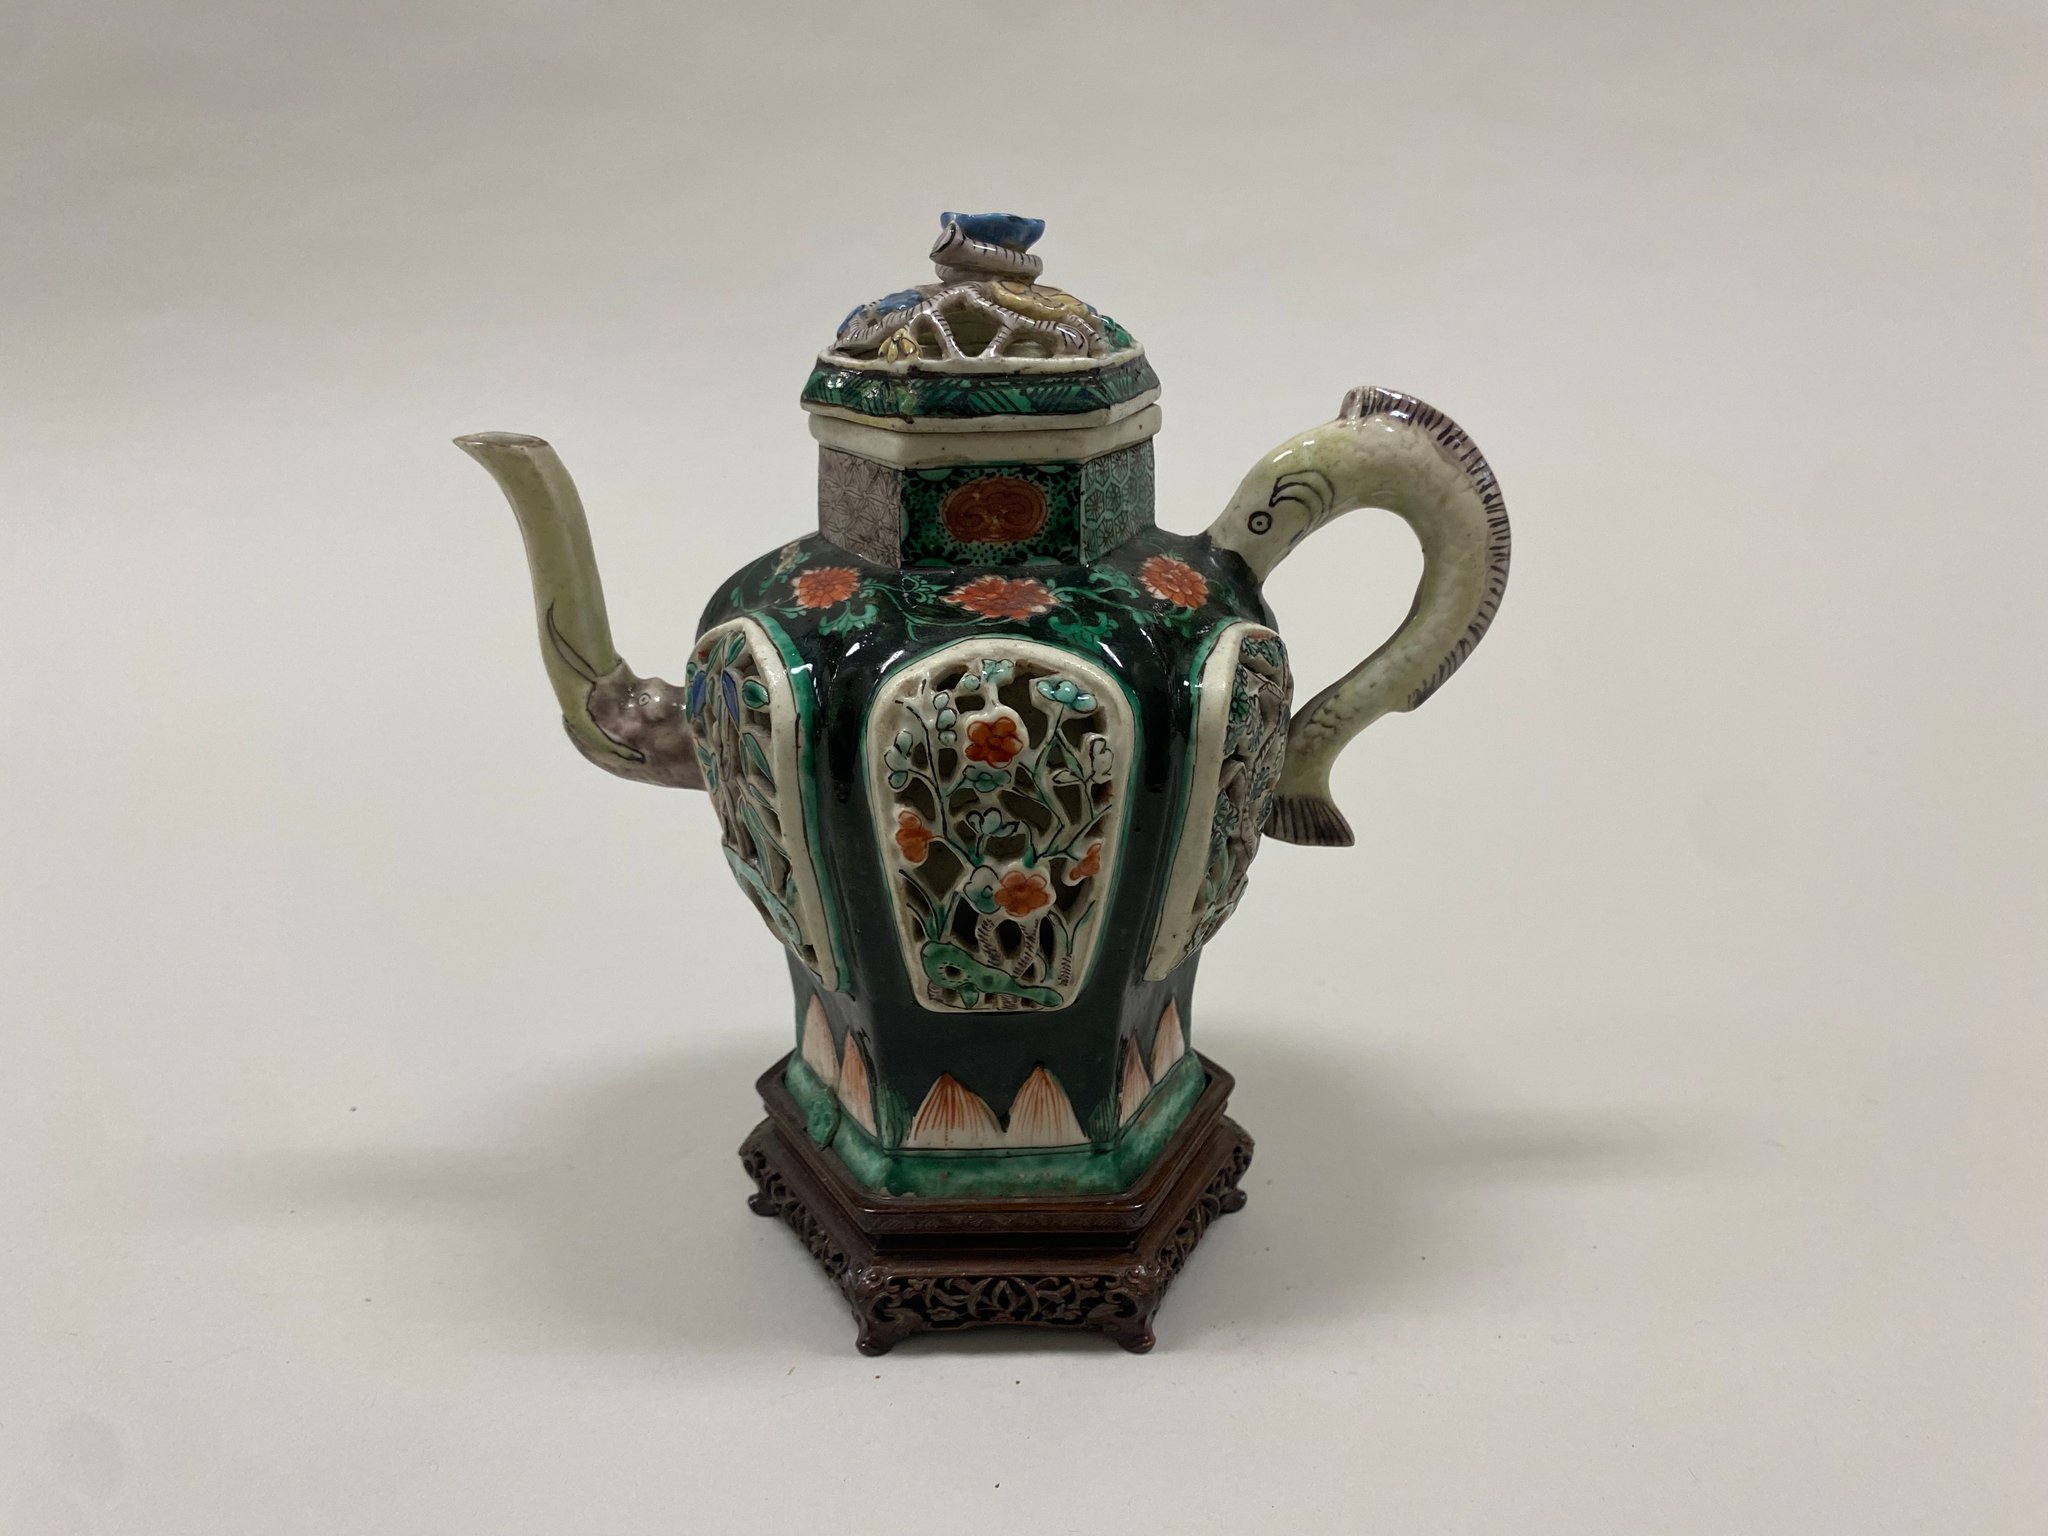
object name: wine pot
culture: chinese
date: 1662-1722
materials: biscuit, enamel, porcelain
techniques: gilding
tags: fish